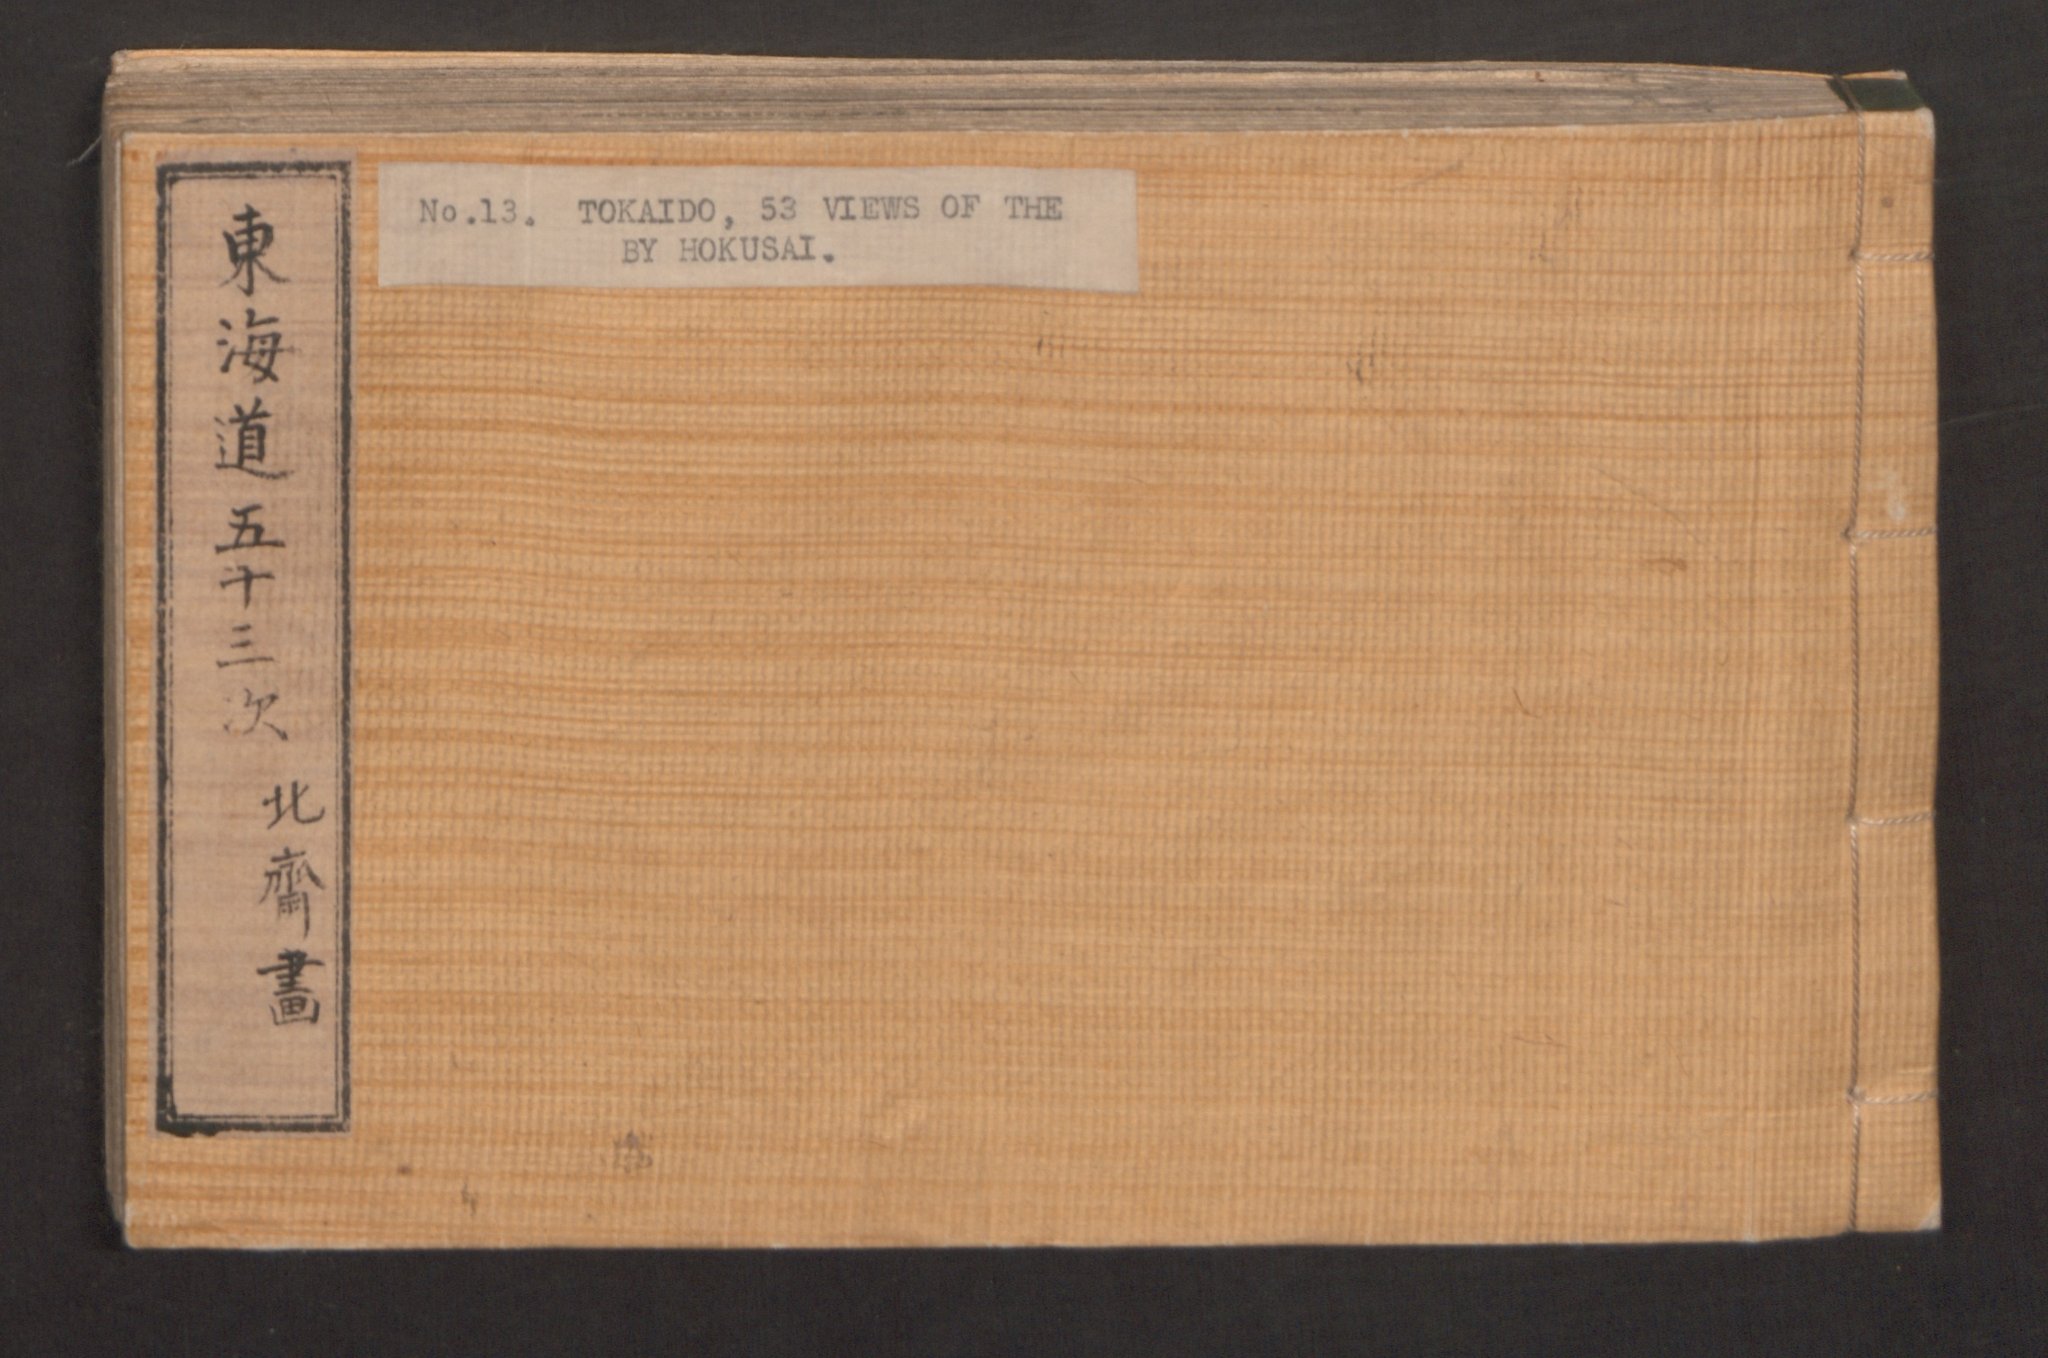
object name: illustrated book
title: Fifty-three Stations on the Tōkaidō Road, Fuchū (Tōkaidō gojūsan-tsugi) 東海道五十三次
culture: japanese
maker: katsushika hokusai 葛飾北斎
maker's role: artist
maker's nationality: japanese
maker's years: 1760-1849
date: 1845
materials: ink, paper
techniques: polychrome, woodblock print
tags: women